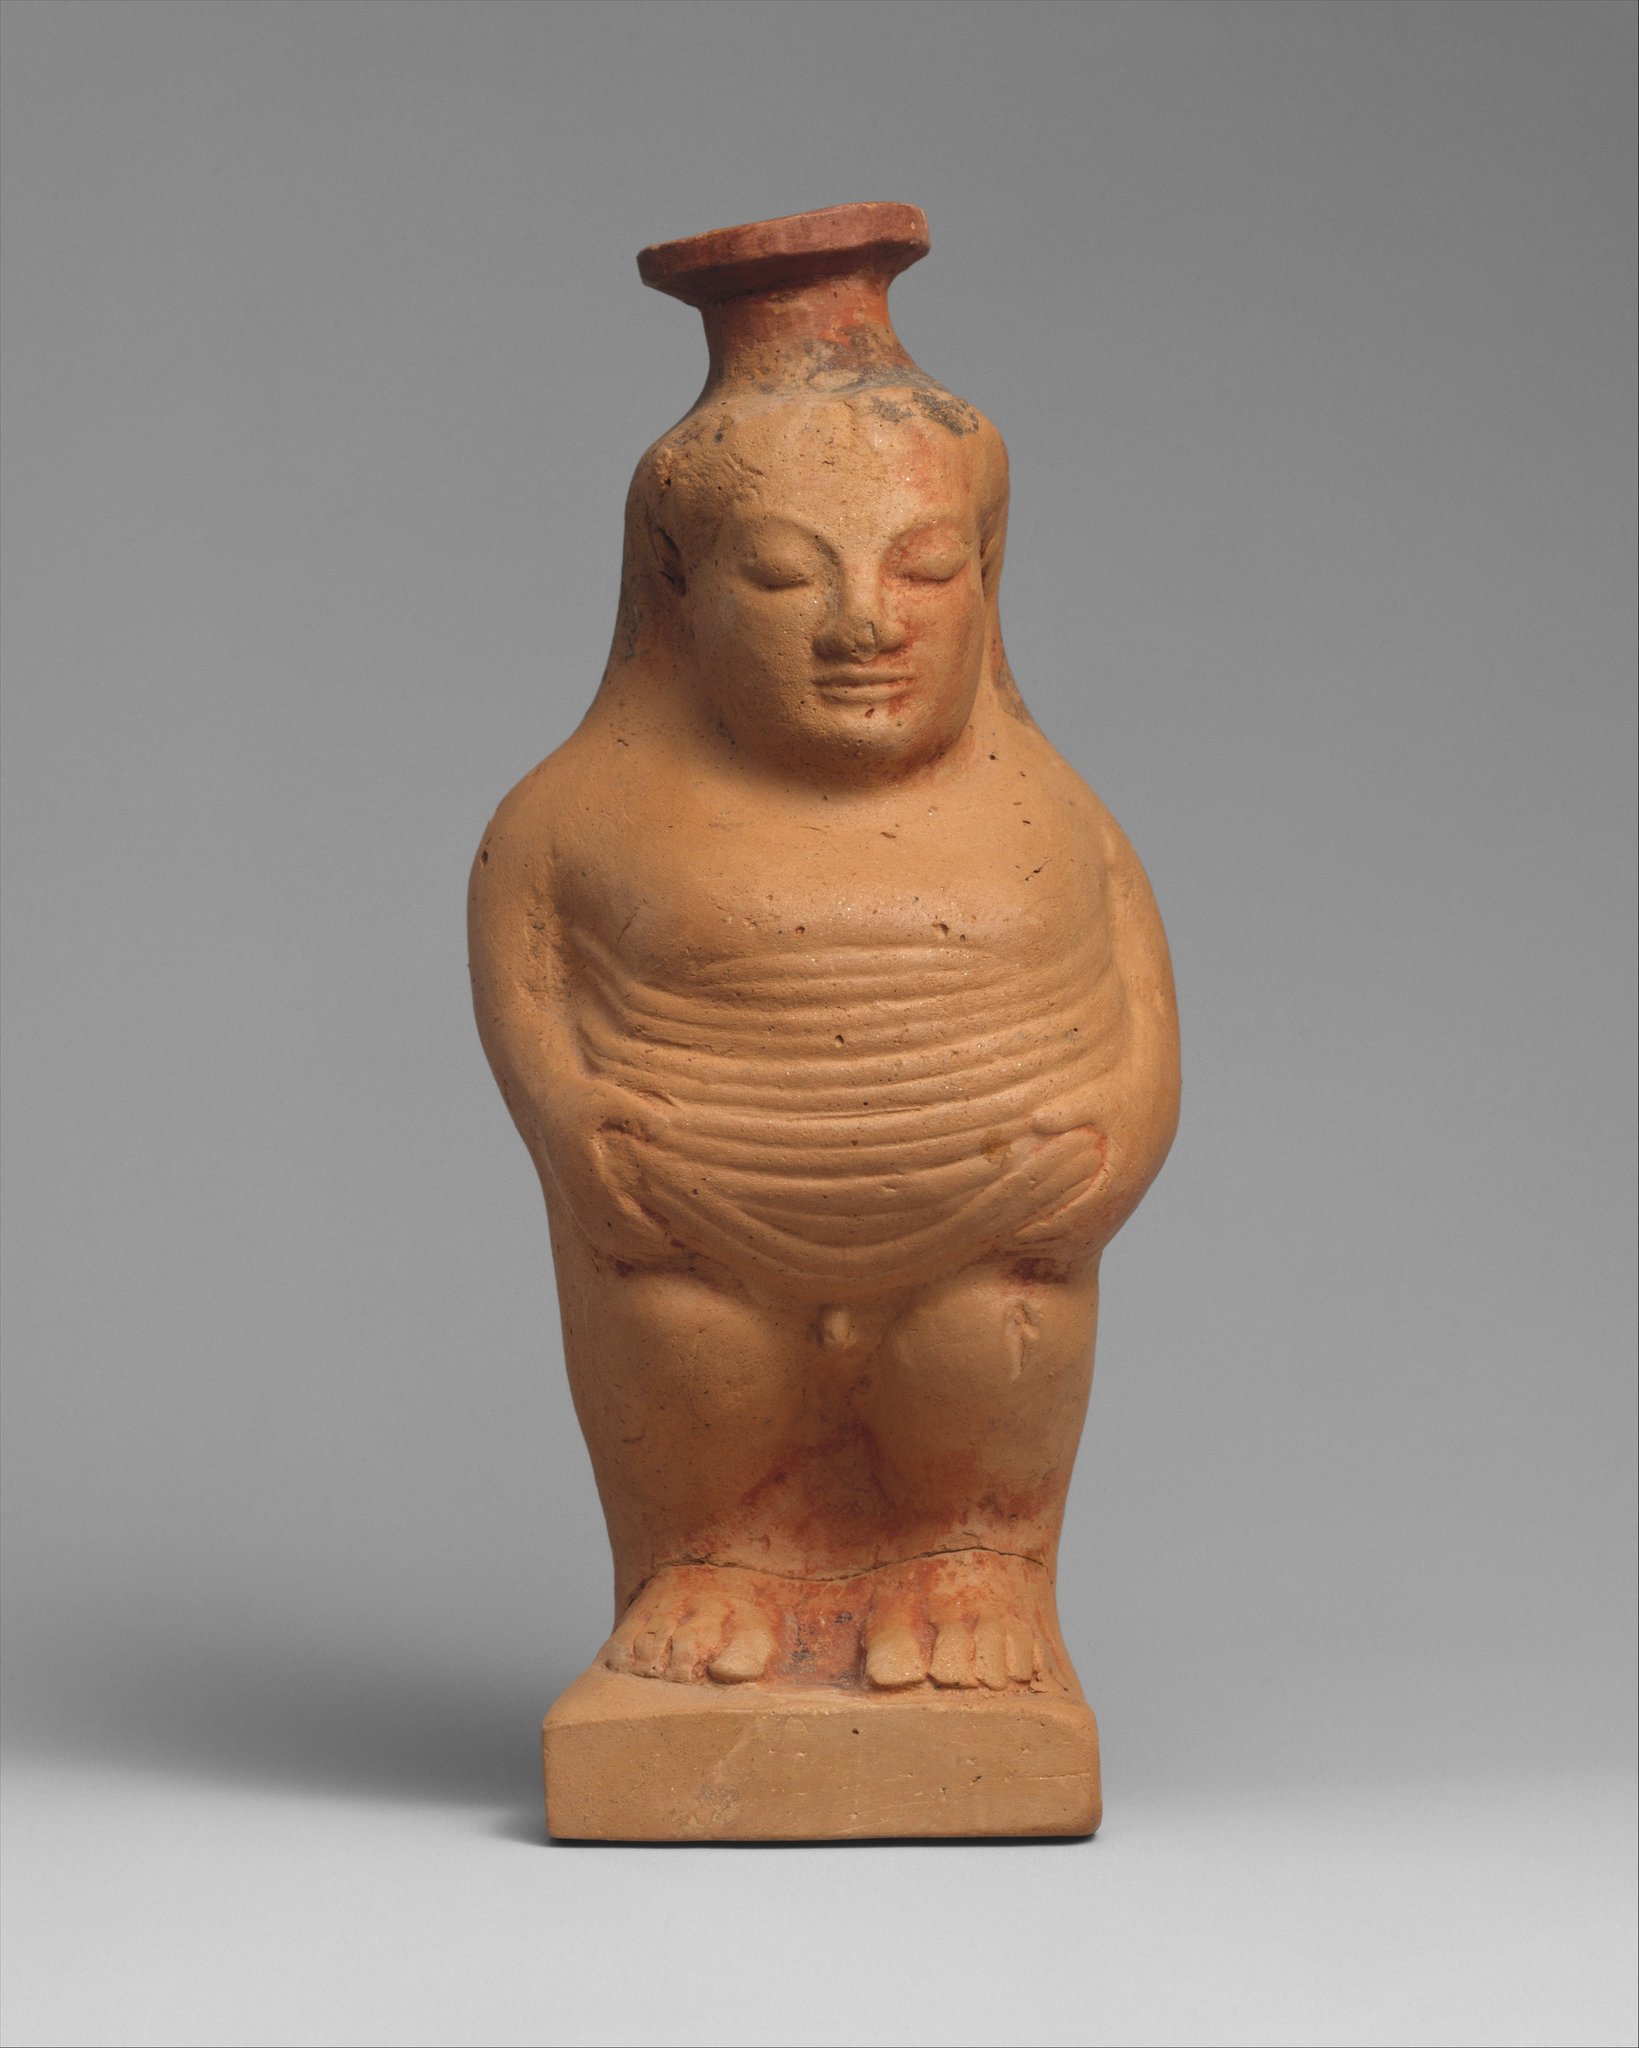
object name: vase in the form of a fat boy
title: Terracotta aryballos (perfume vase) in the form of a boy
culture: east greek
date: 540-530 BCE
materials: terracotta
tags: boys